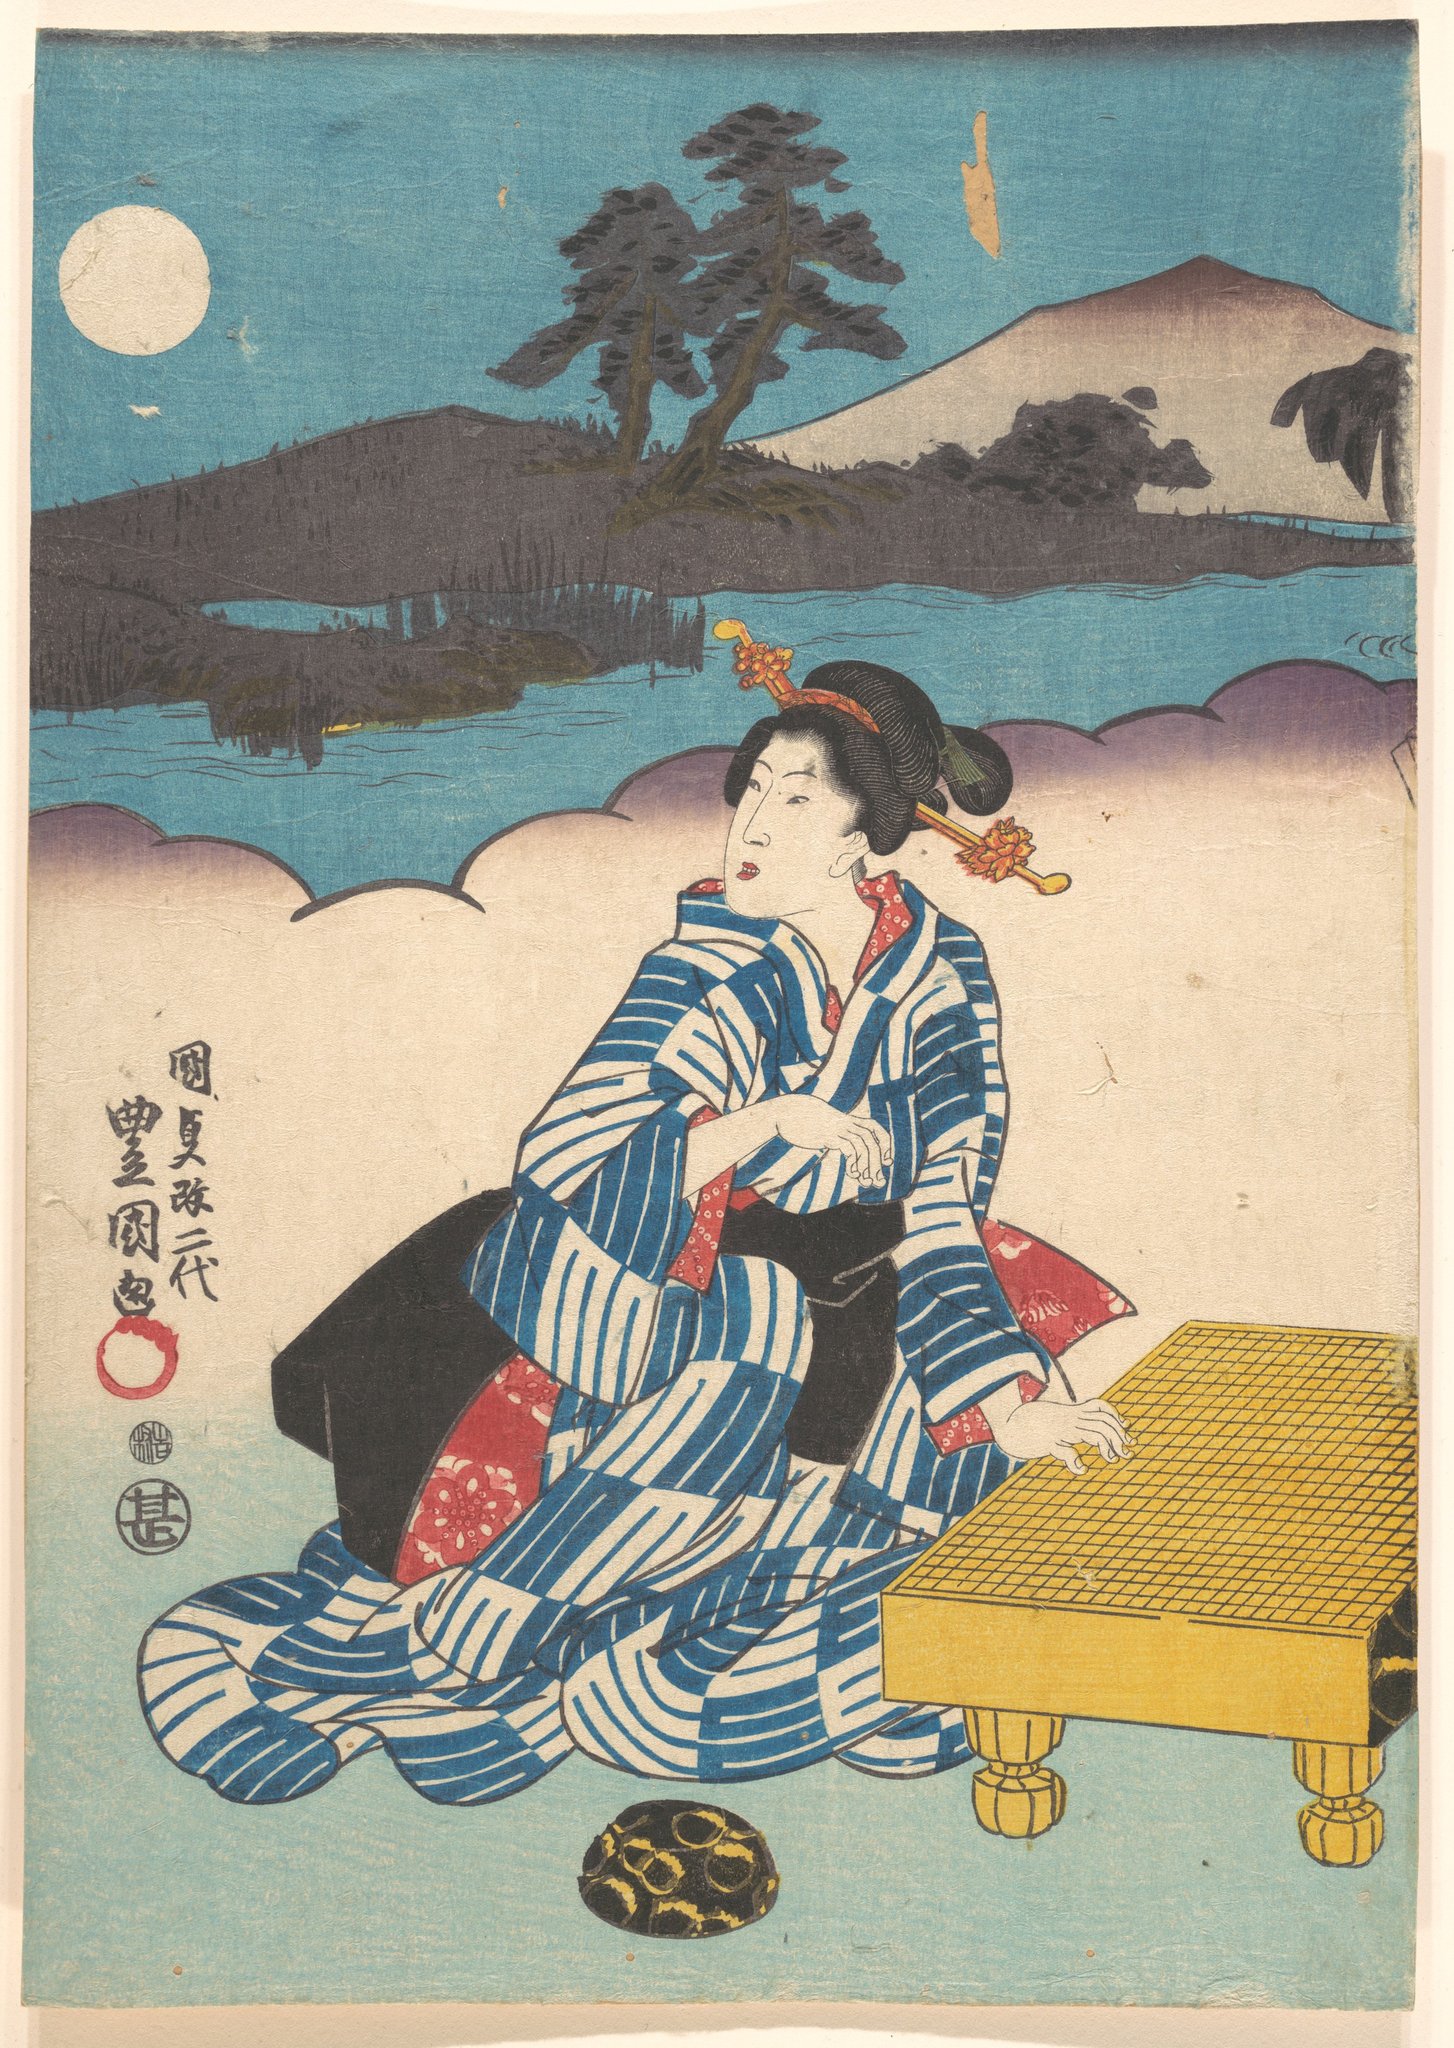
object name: print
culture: japanese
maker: utagawa kunisada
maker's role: artist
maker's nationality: japanese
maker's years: 1786-1864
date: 1786-1854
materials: ink, paper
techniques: woodblock print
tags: women,moon,mountains